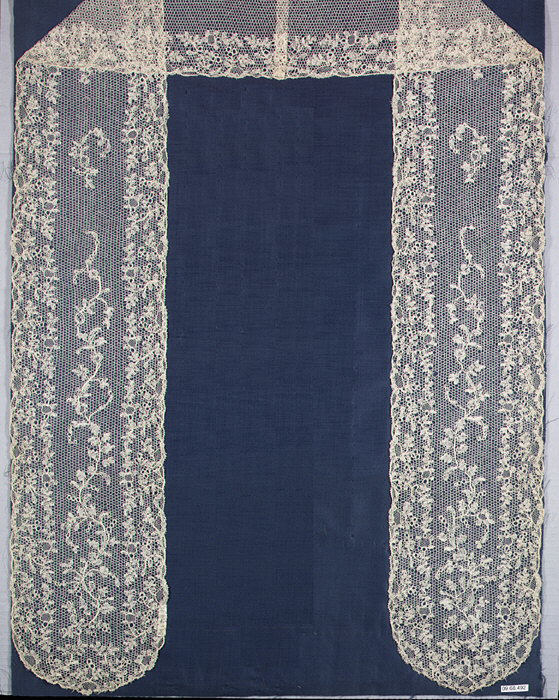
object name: lappet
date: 1801-1900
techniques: lace